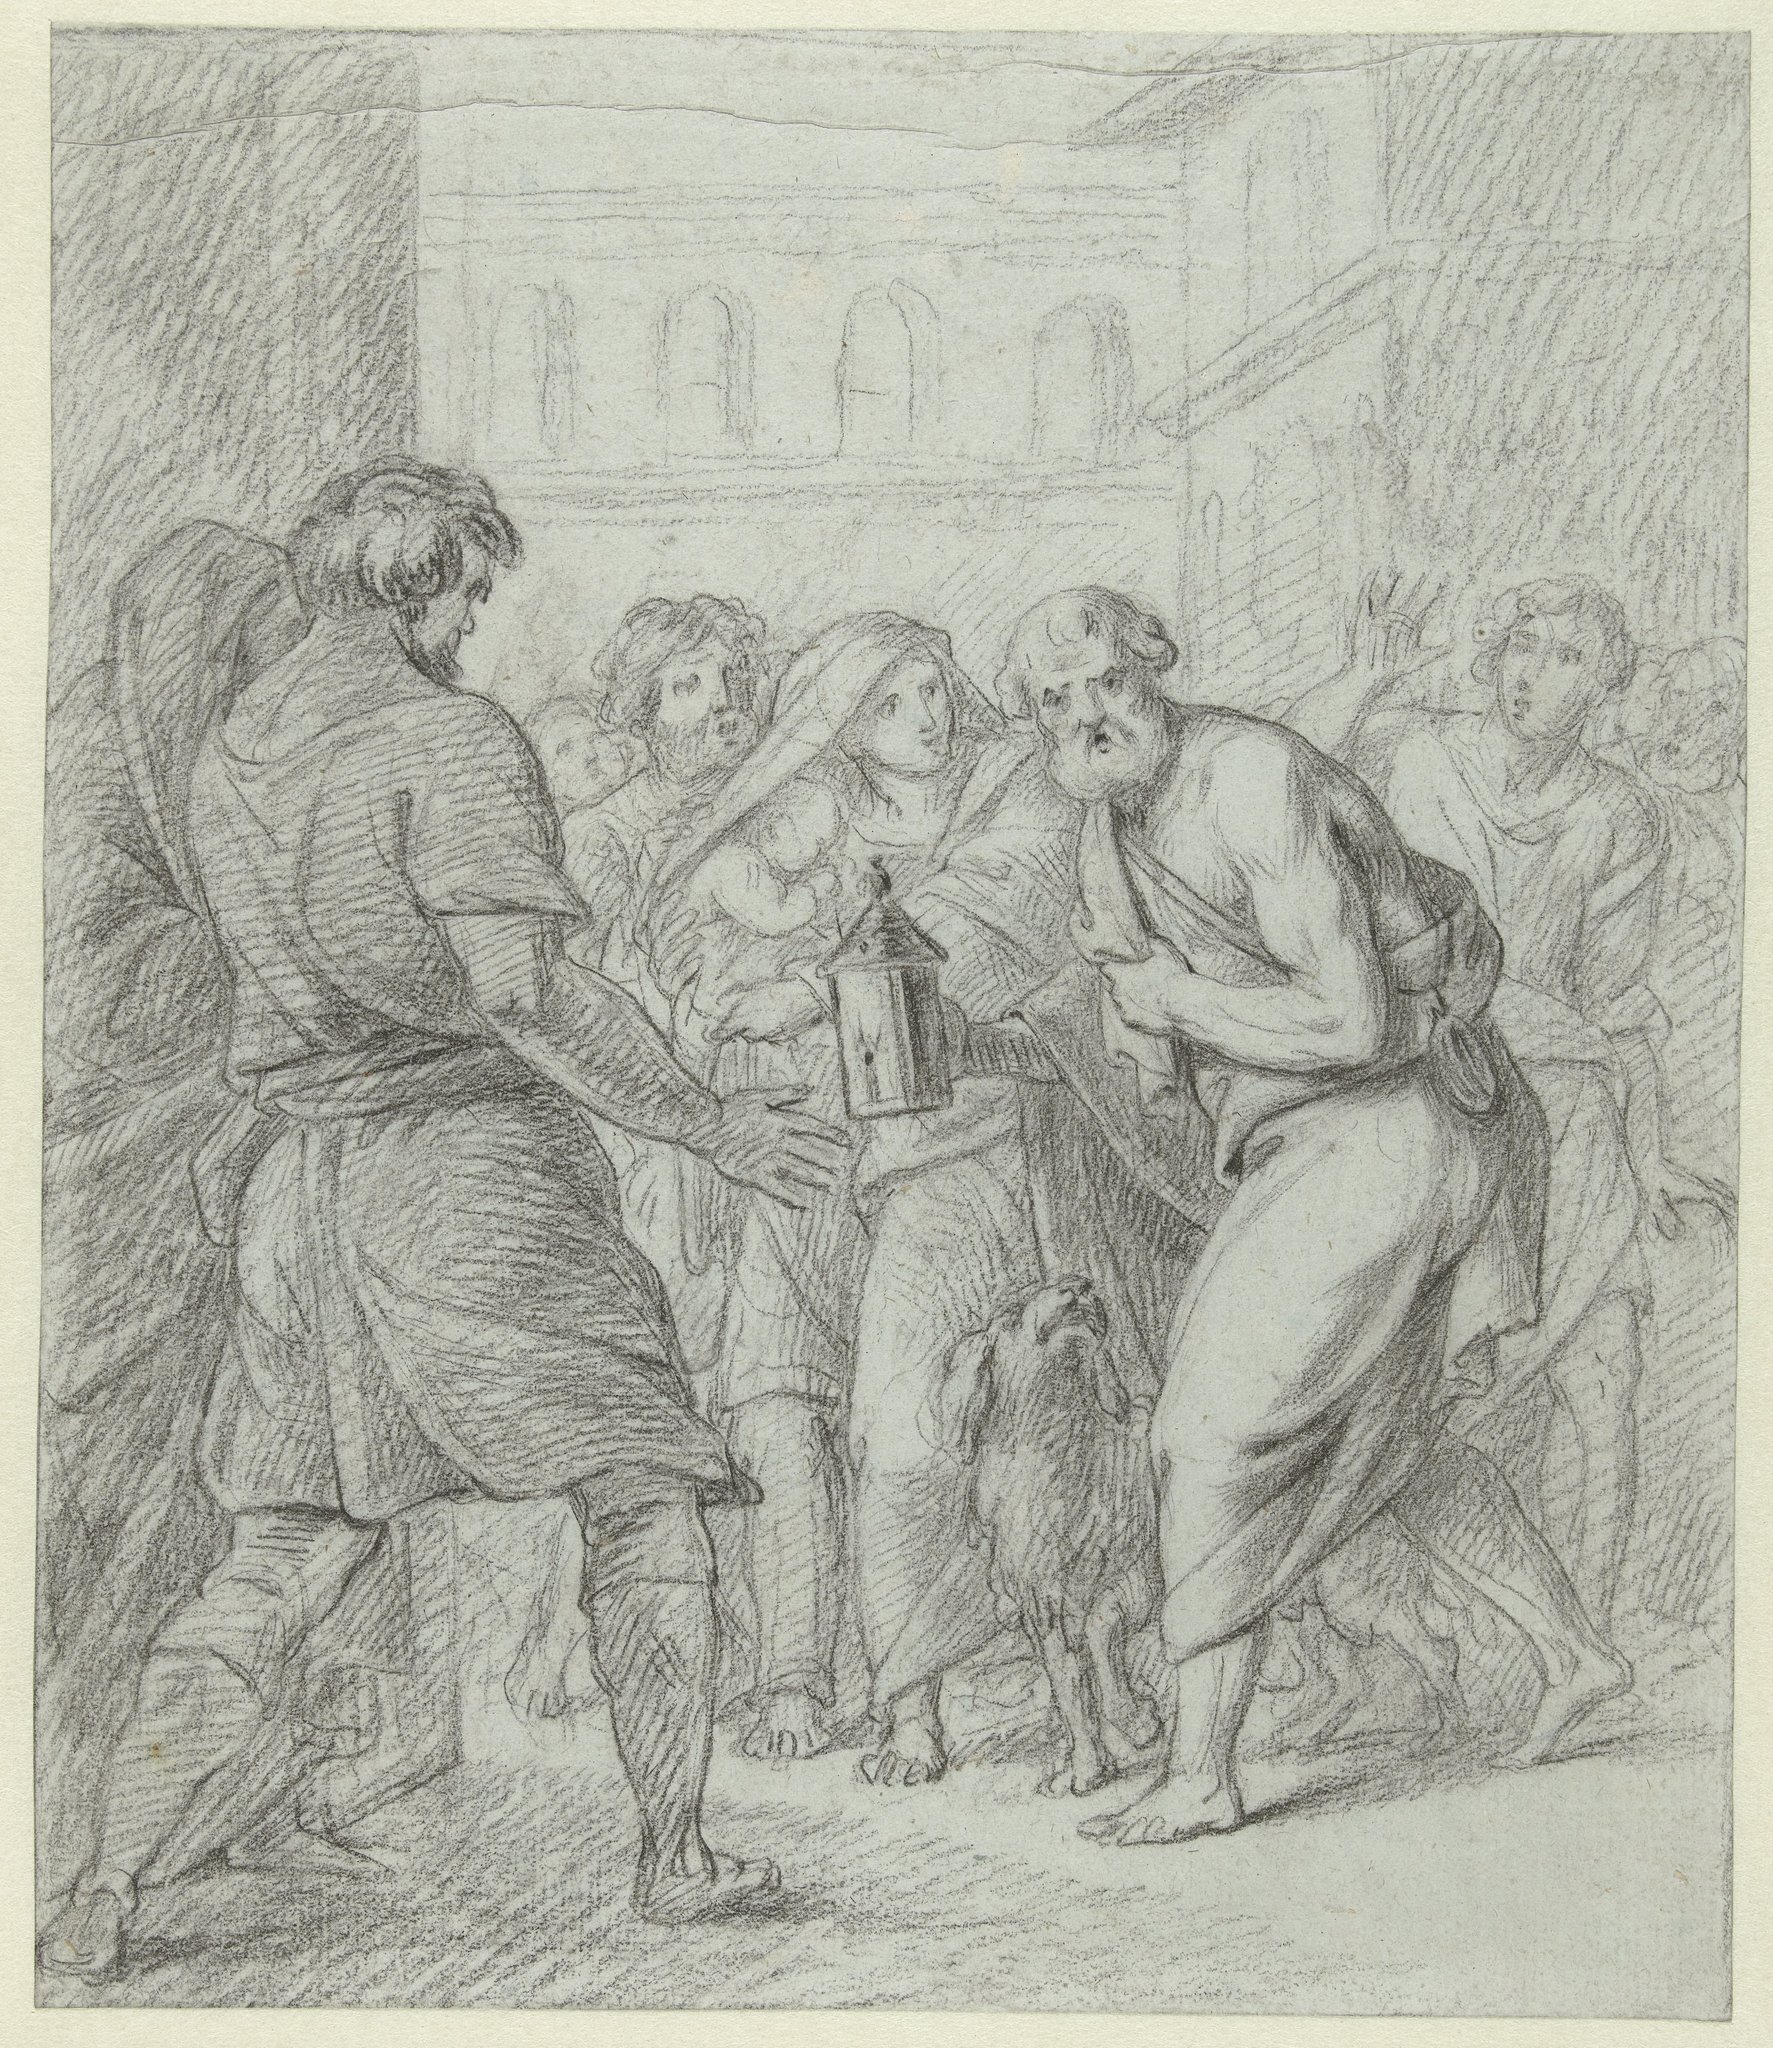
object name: drawing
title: Diogenes met de lamp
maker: Anonymous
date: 1600-1699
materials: chalk, paper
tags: diogenes, carrying a lighted lantarn by daylight, trying to find an honest man, usually in a crowded market-place